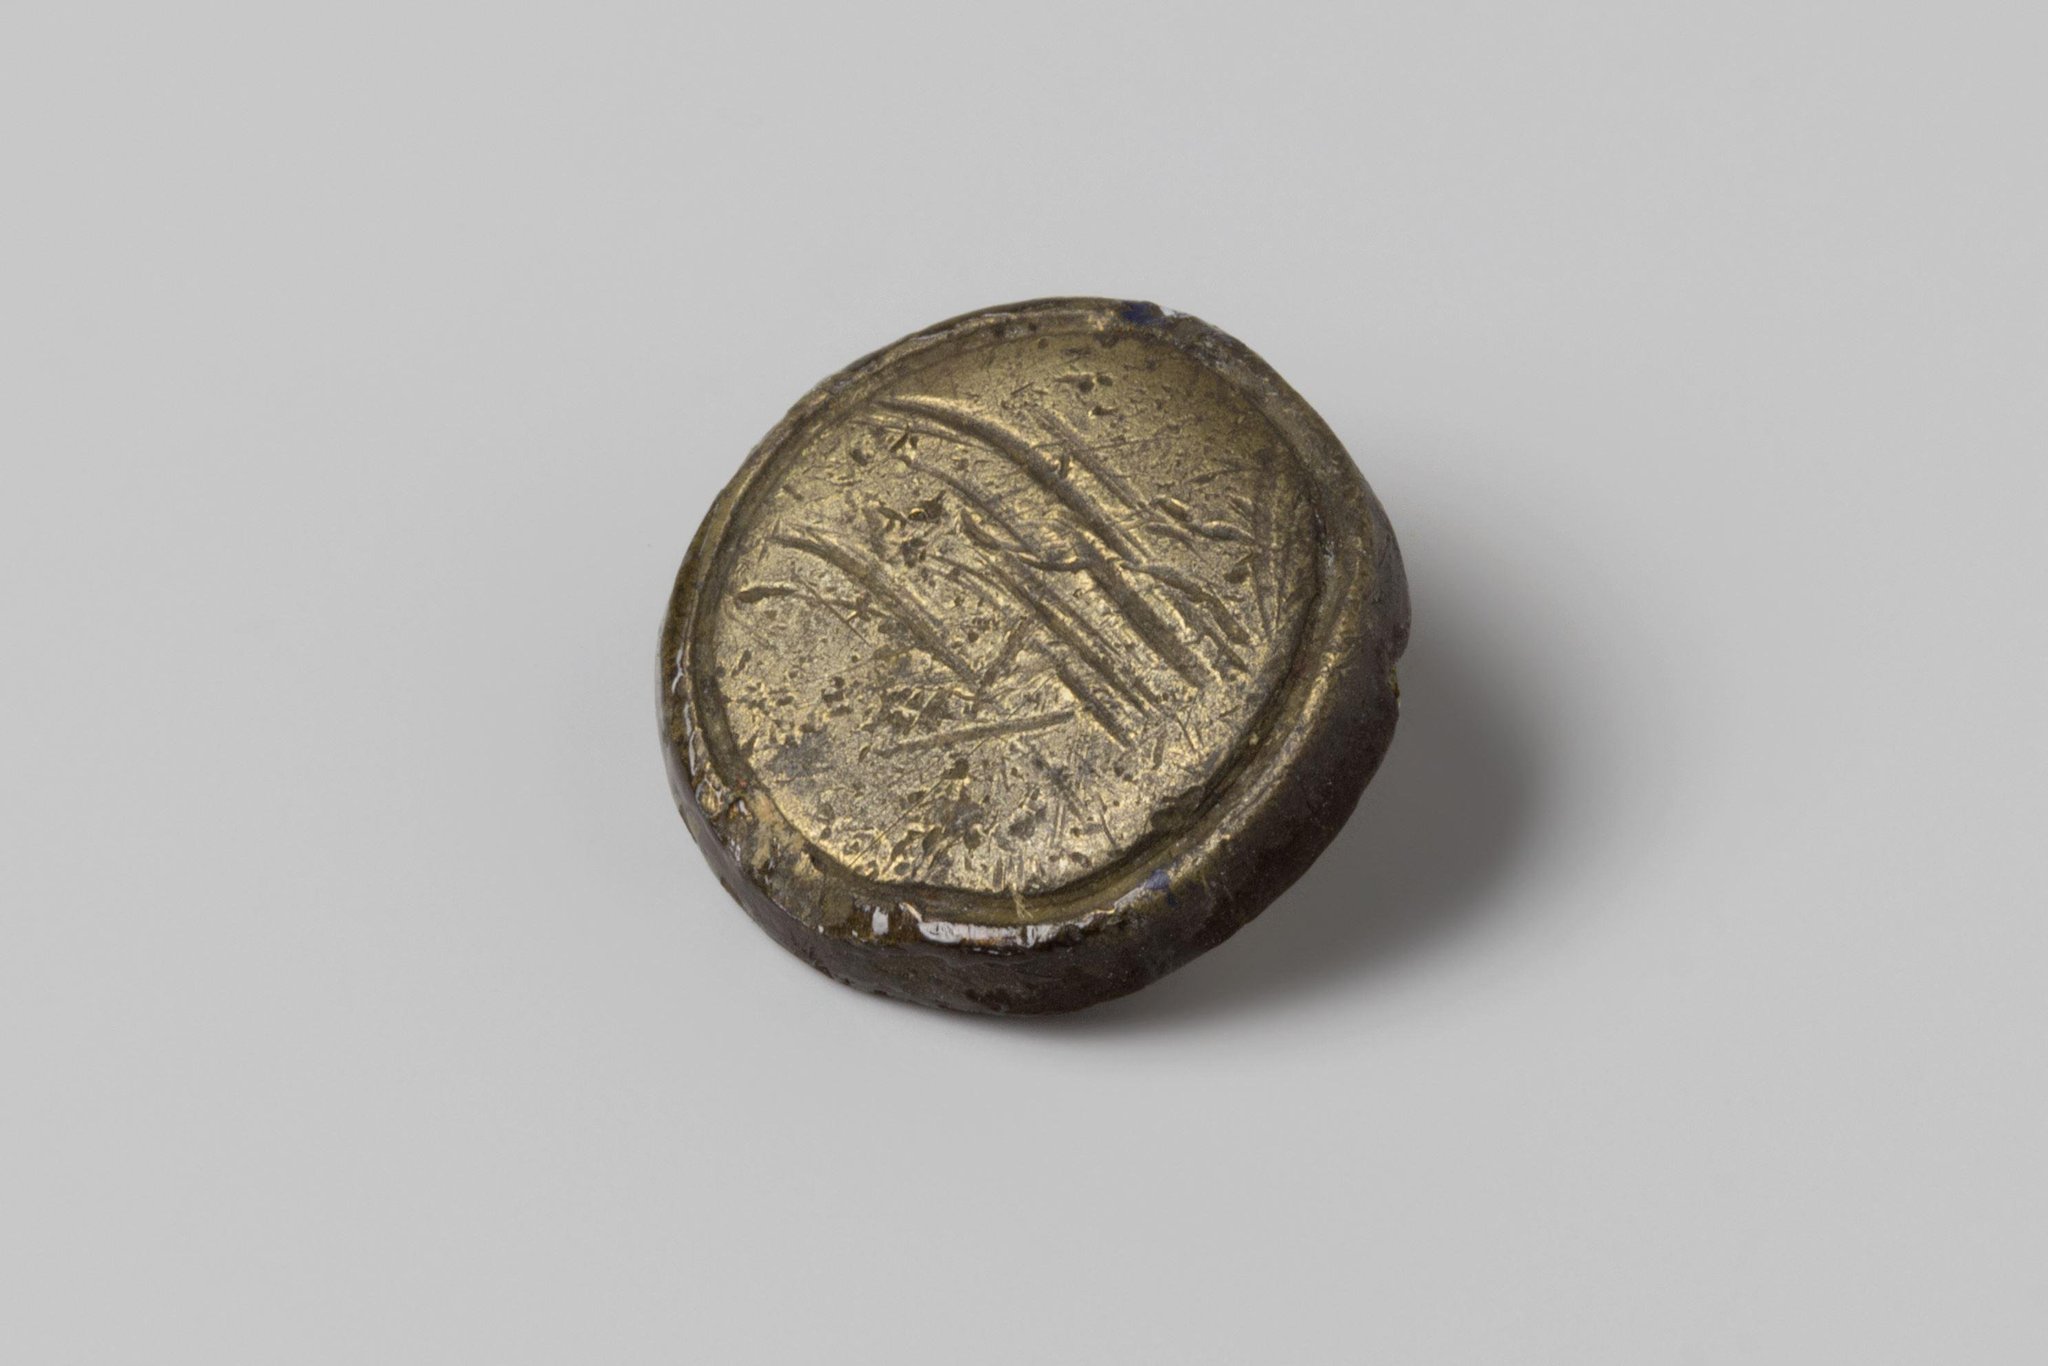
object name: button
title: Knoop uit het wrak van de Oost-Indiëvaarder Hollandia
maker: Anonymous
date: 1700-1743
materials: copper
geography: netherlands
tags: verenigde oostindische compagnie, hollandia (schip), annet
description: Knoop. (1) sim. NG 1980-27H1306 (1.6d) shank broken